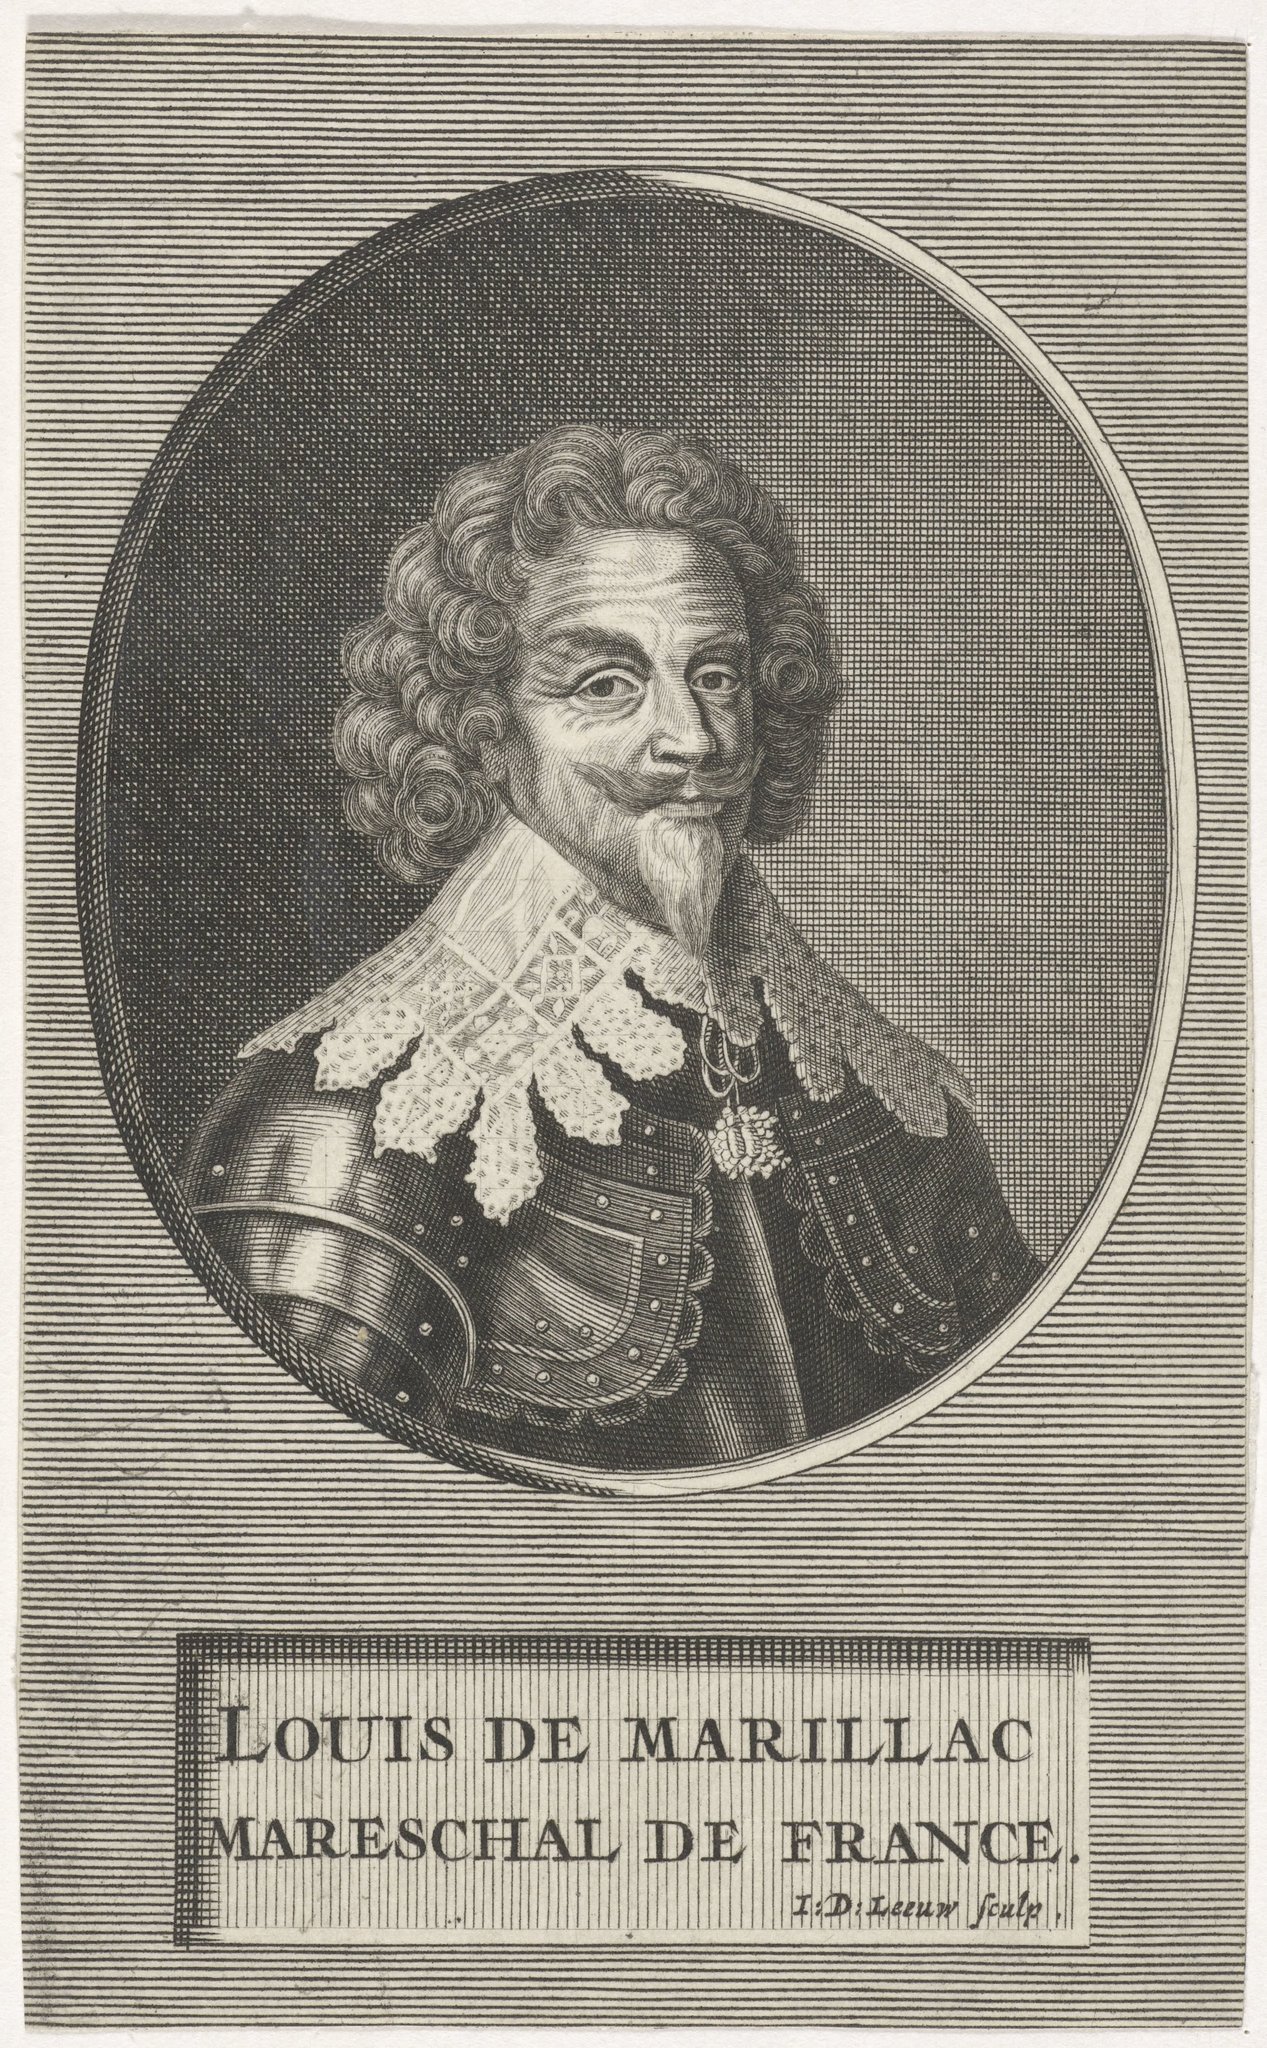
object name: print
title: Portret van Louis de Marillac, graaf van Beaumont-le-Roger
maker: jan de leeuw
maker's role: print maker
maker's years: 1660-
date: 1704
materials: paper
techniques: engraving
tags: paris, earl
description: Portretbuste in ovaal naar rechts van Louis de Marillac, graaf van Beaumont-le-Roger, blootshoofds en gehuld in een harnas. Onder het portret staan op een plaquette de naam en titel van de geportretteerde in het Frans.